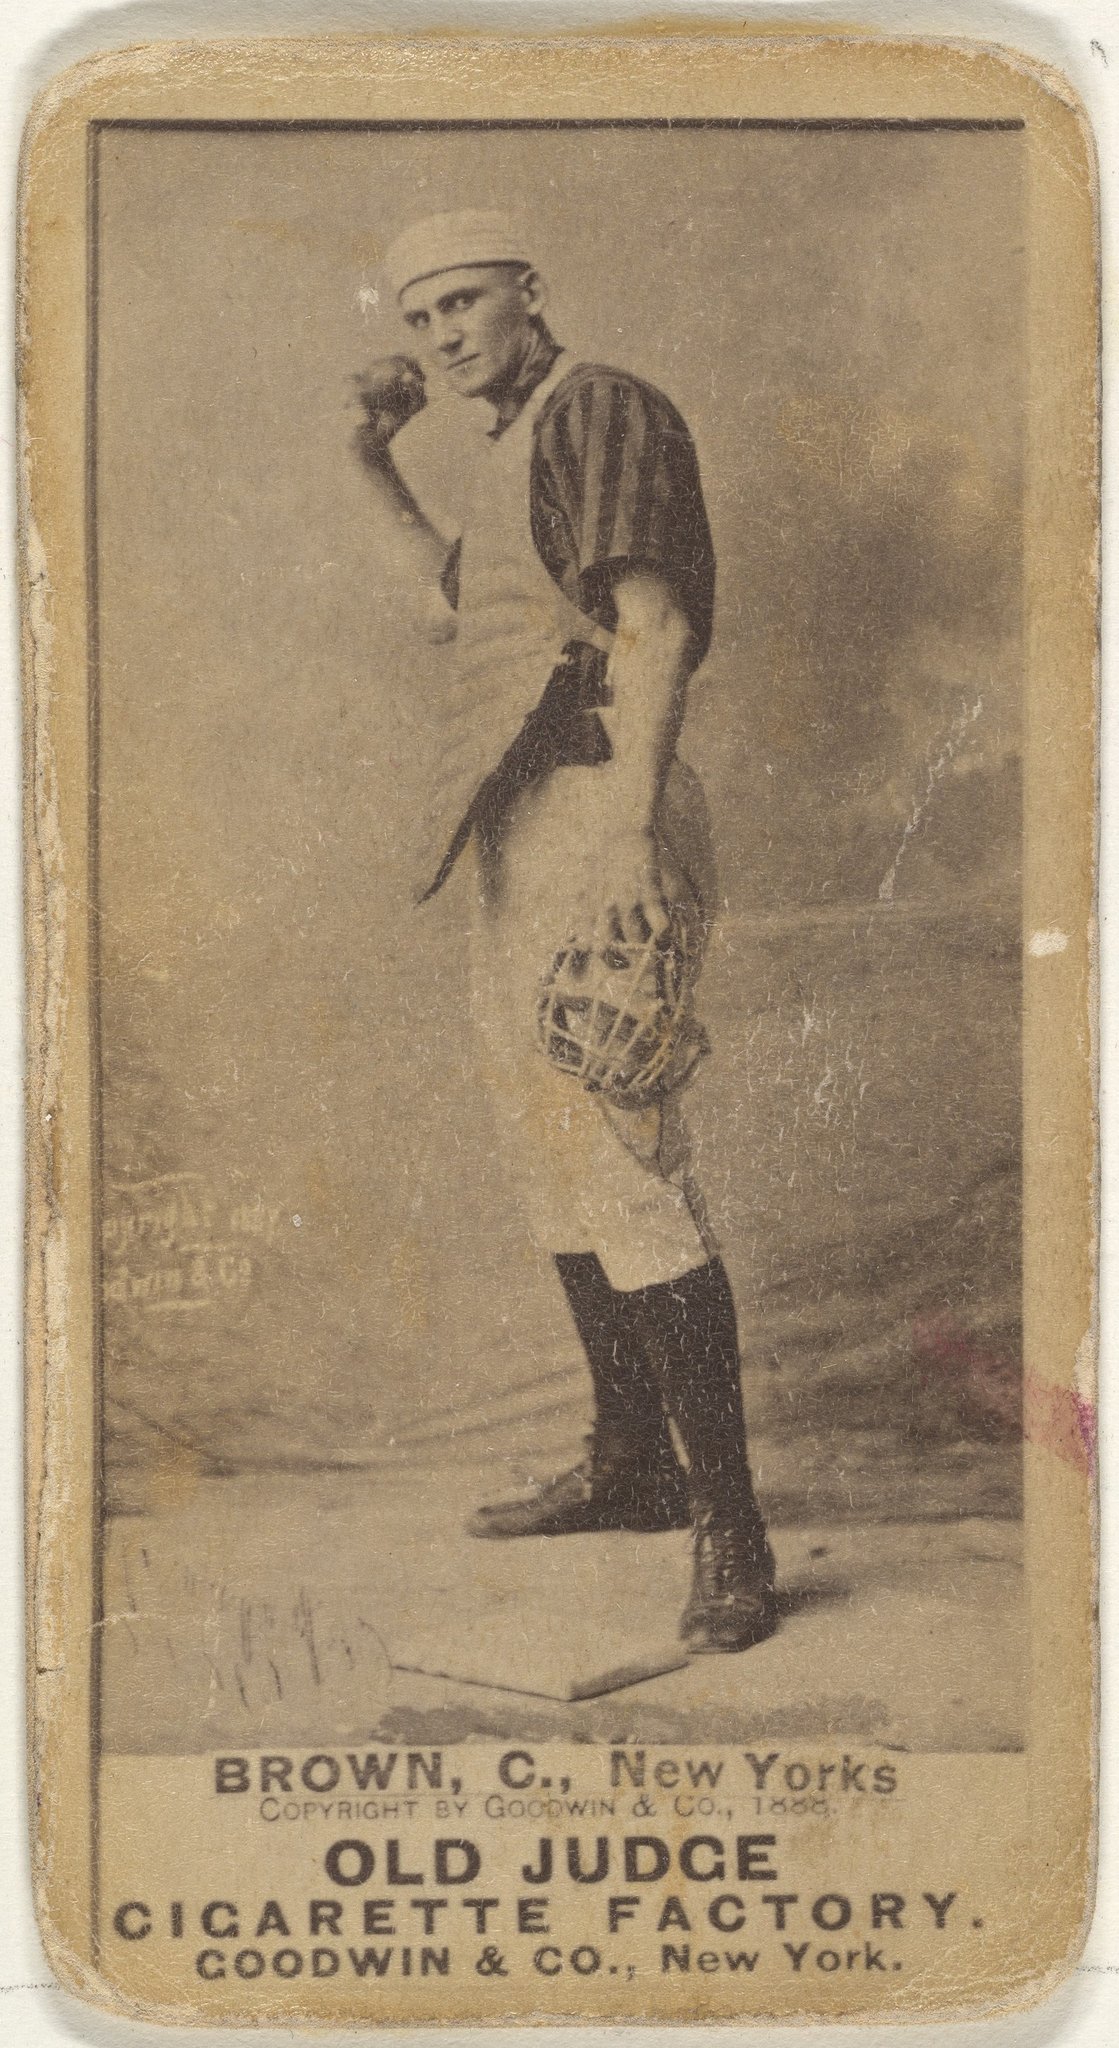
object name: baseball card, photograph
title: William "California" Brown, Catcher, New York, from the Old Judge series (N172) for Old Judge Cigarettes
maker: goodwin & company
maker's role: publisher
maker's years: 1850-1950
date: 1888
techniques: albumen silver print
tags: men,portraits,baseball,athletes